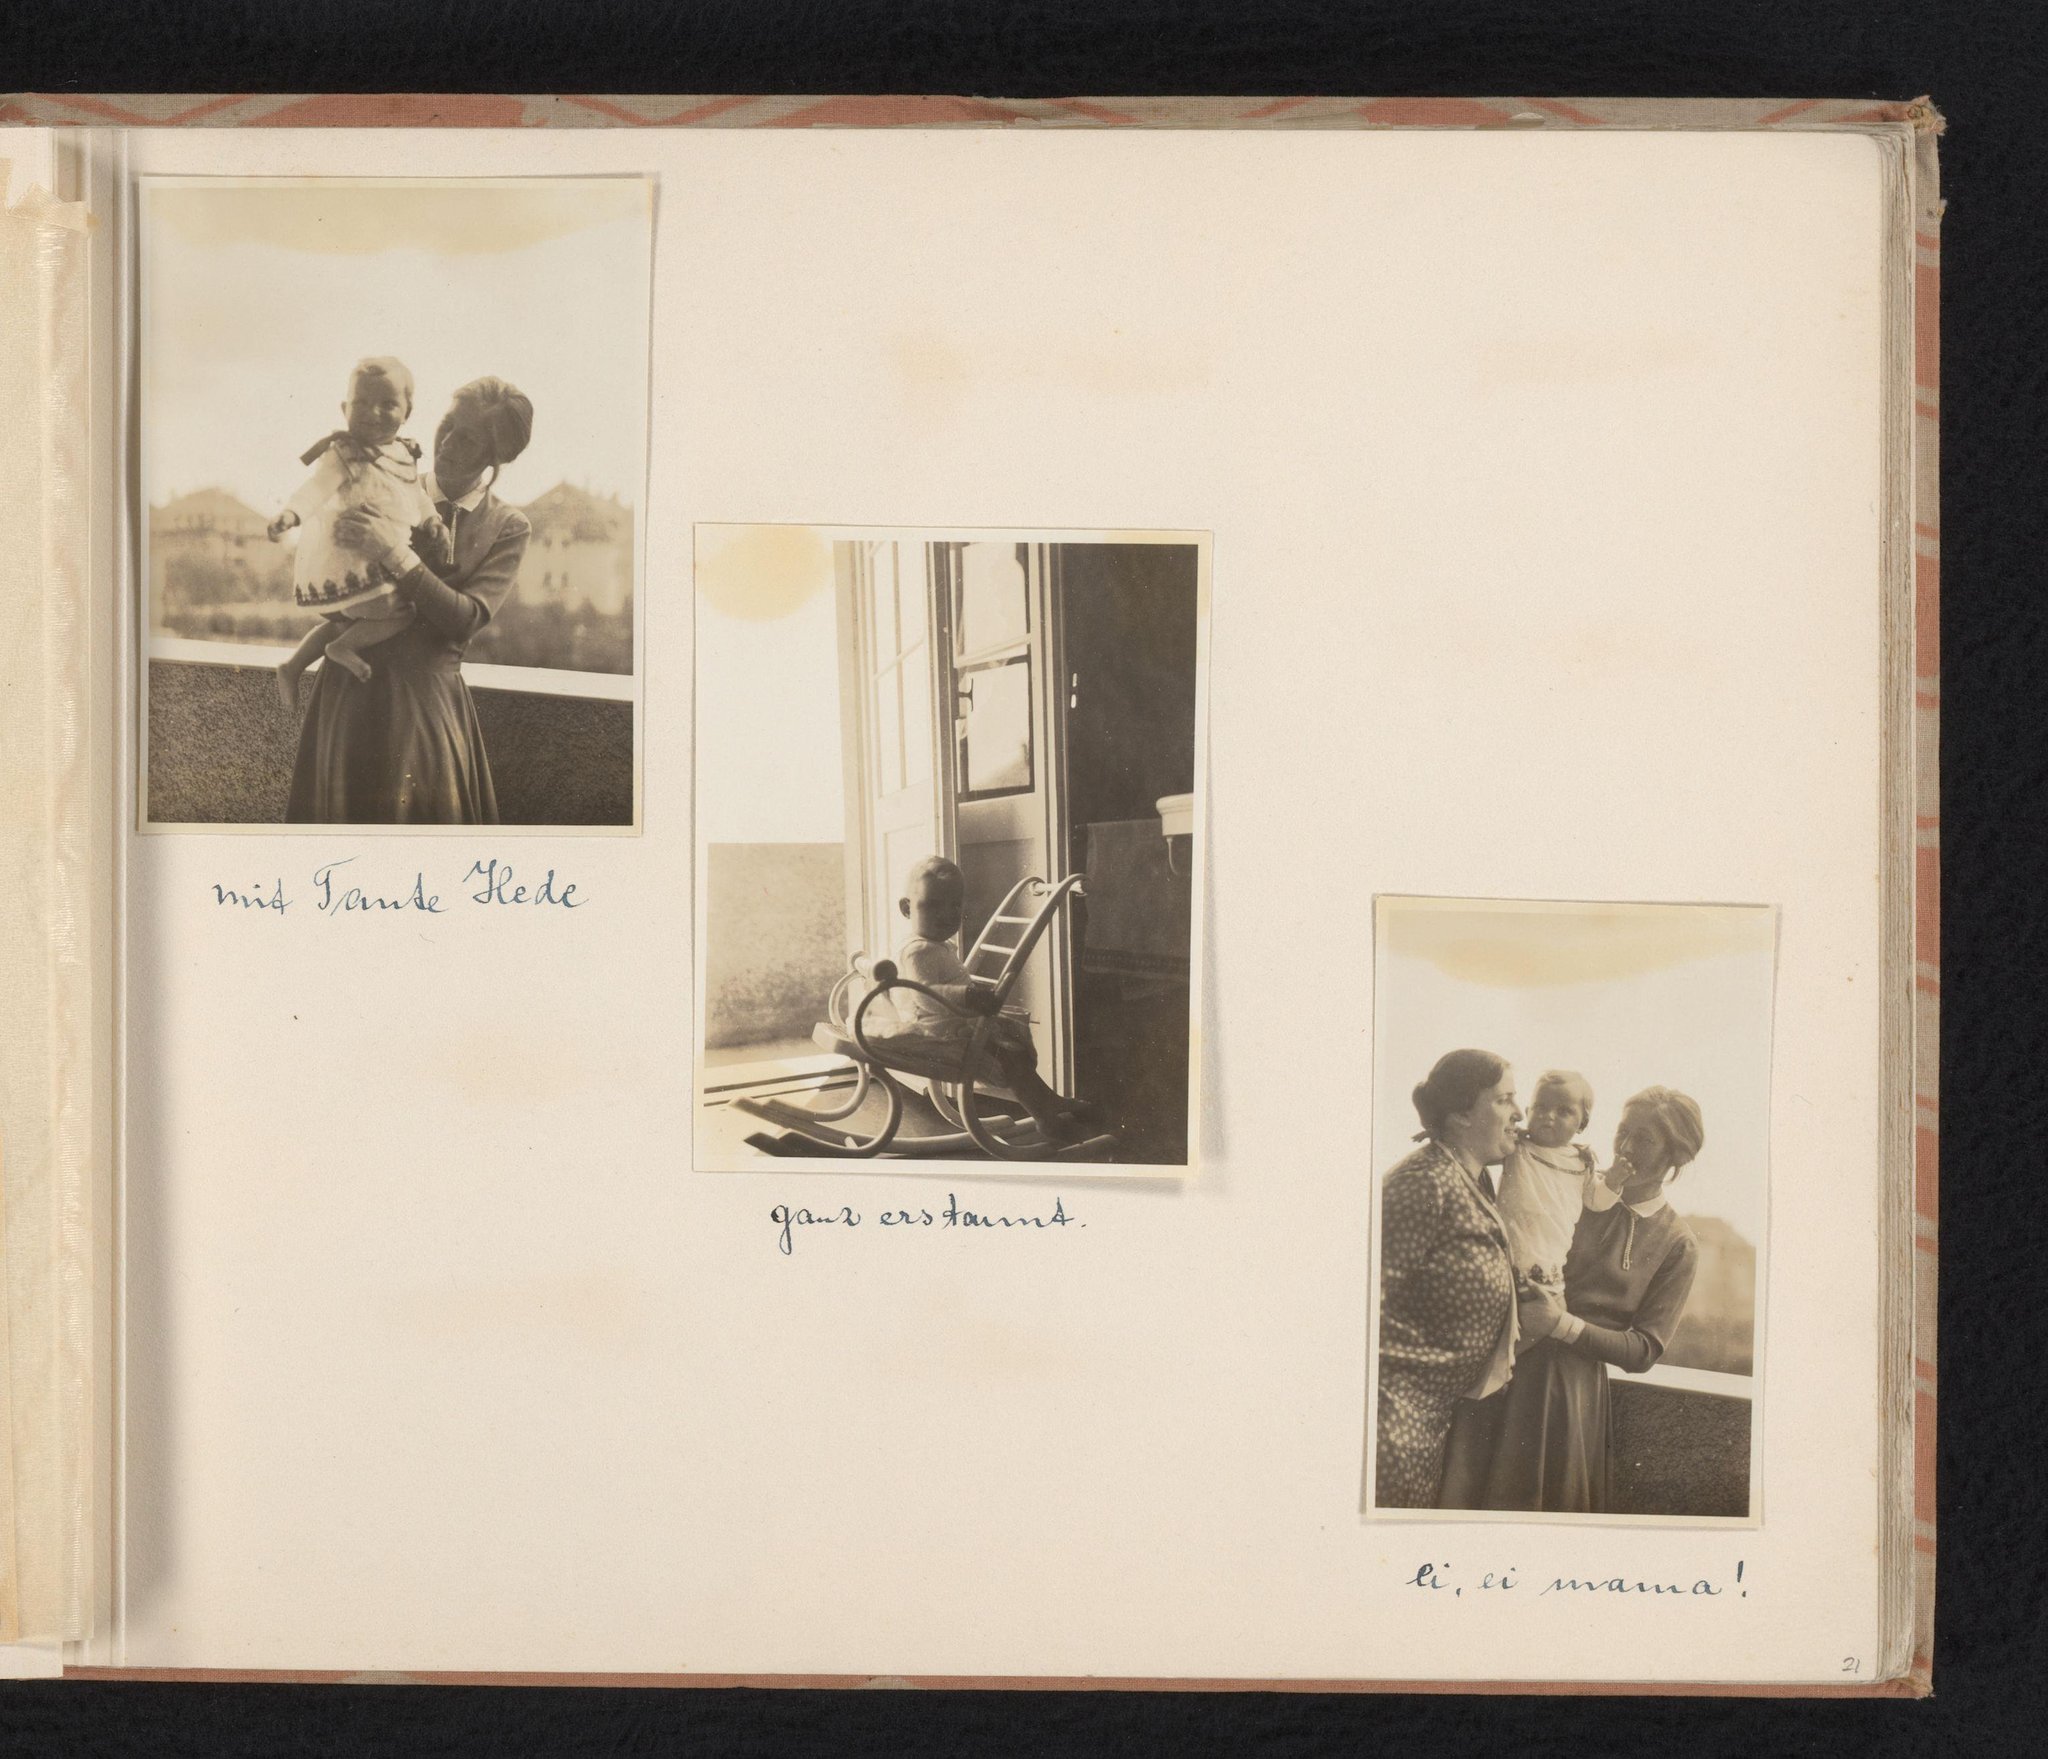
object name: photograph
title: Isabel Wachenheimer op het balkon van de woning van de familie Wachenheimer (Hertastrasse 19) met haar moeder Else Wachenheimer-Moos en tante Hede, mei-juni 1929, Neurenberg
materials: paper, photographic support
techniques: gelatin silver print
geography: nuremberg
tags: else wachenheimer-moos, leiden, isabel wachenheimer-elon, family life at home, mother and baby or young child, infant, baby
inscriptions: inscription: ‘mit tannte Hede//ganz erstannt//ei, ei mama!’